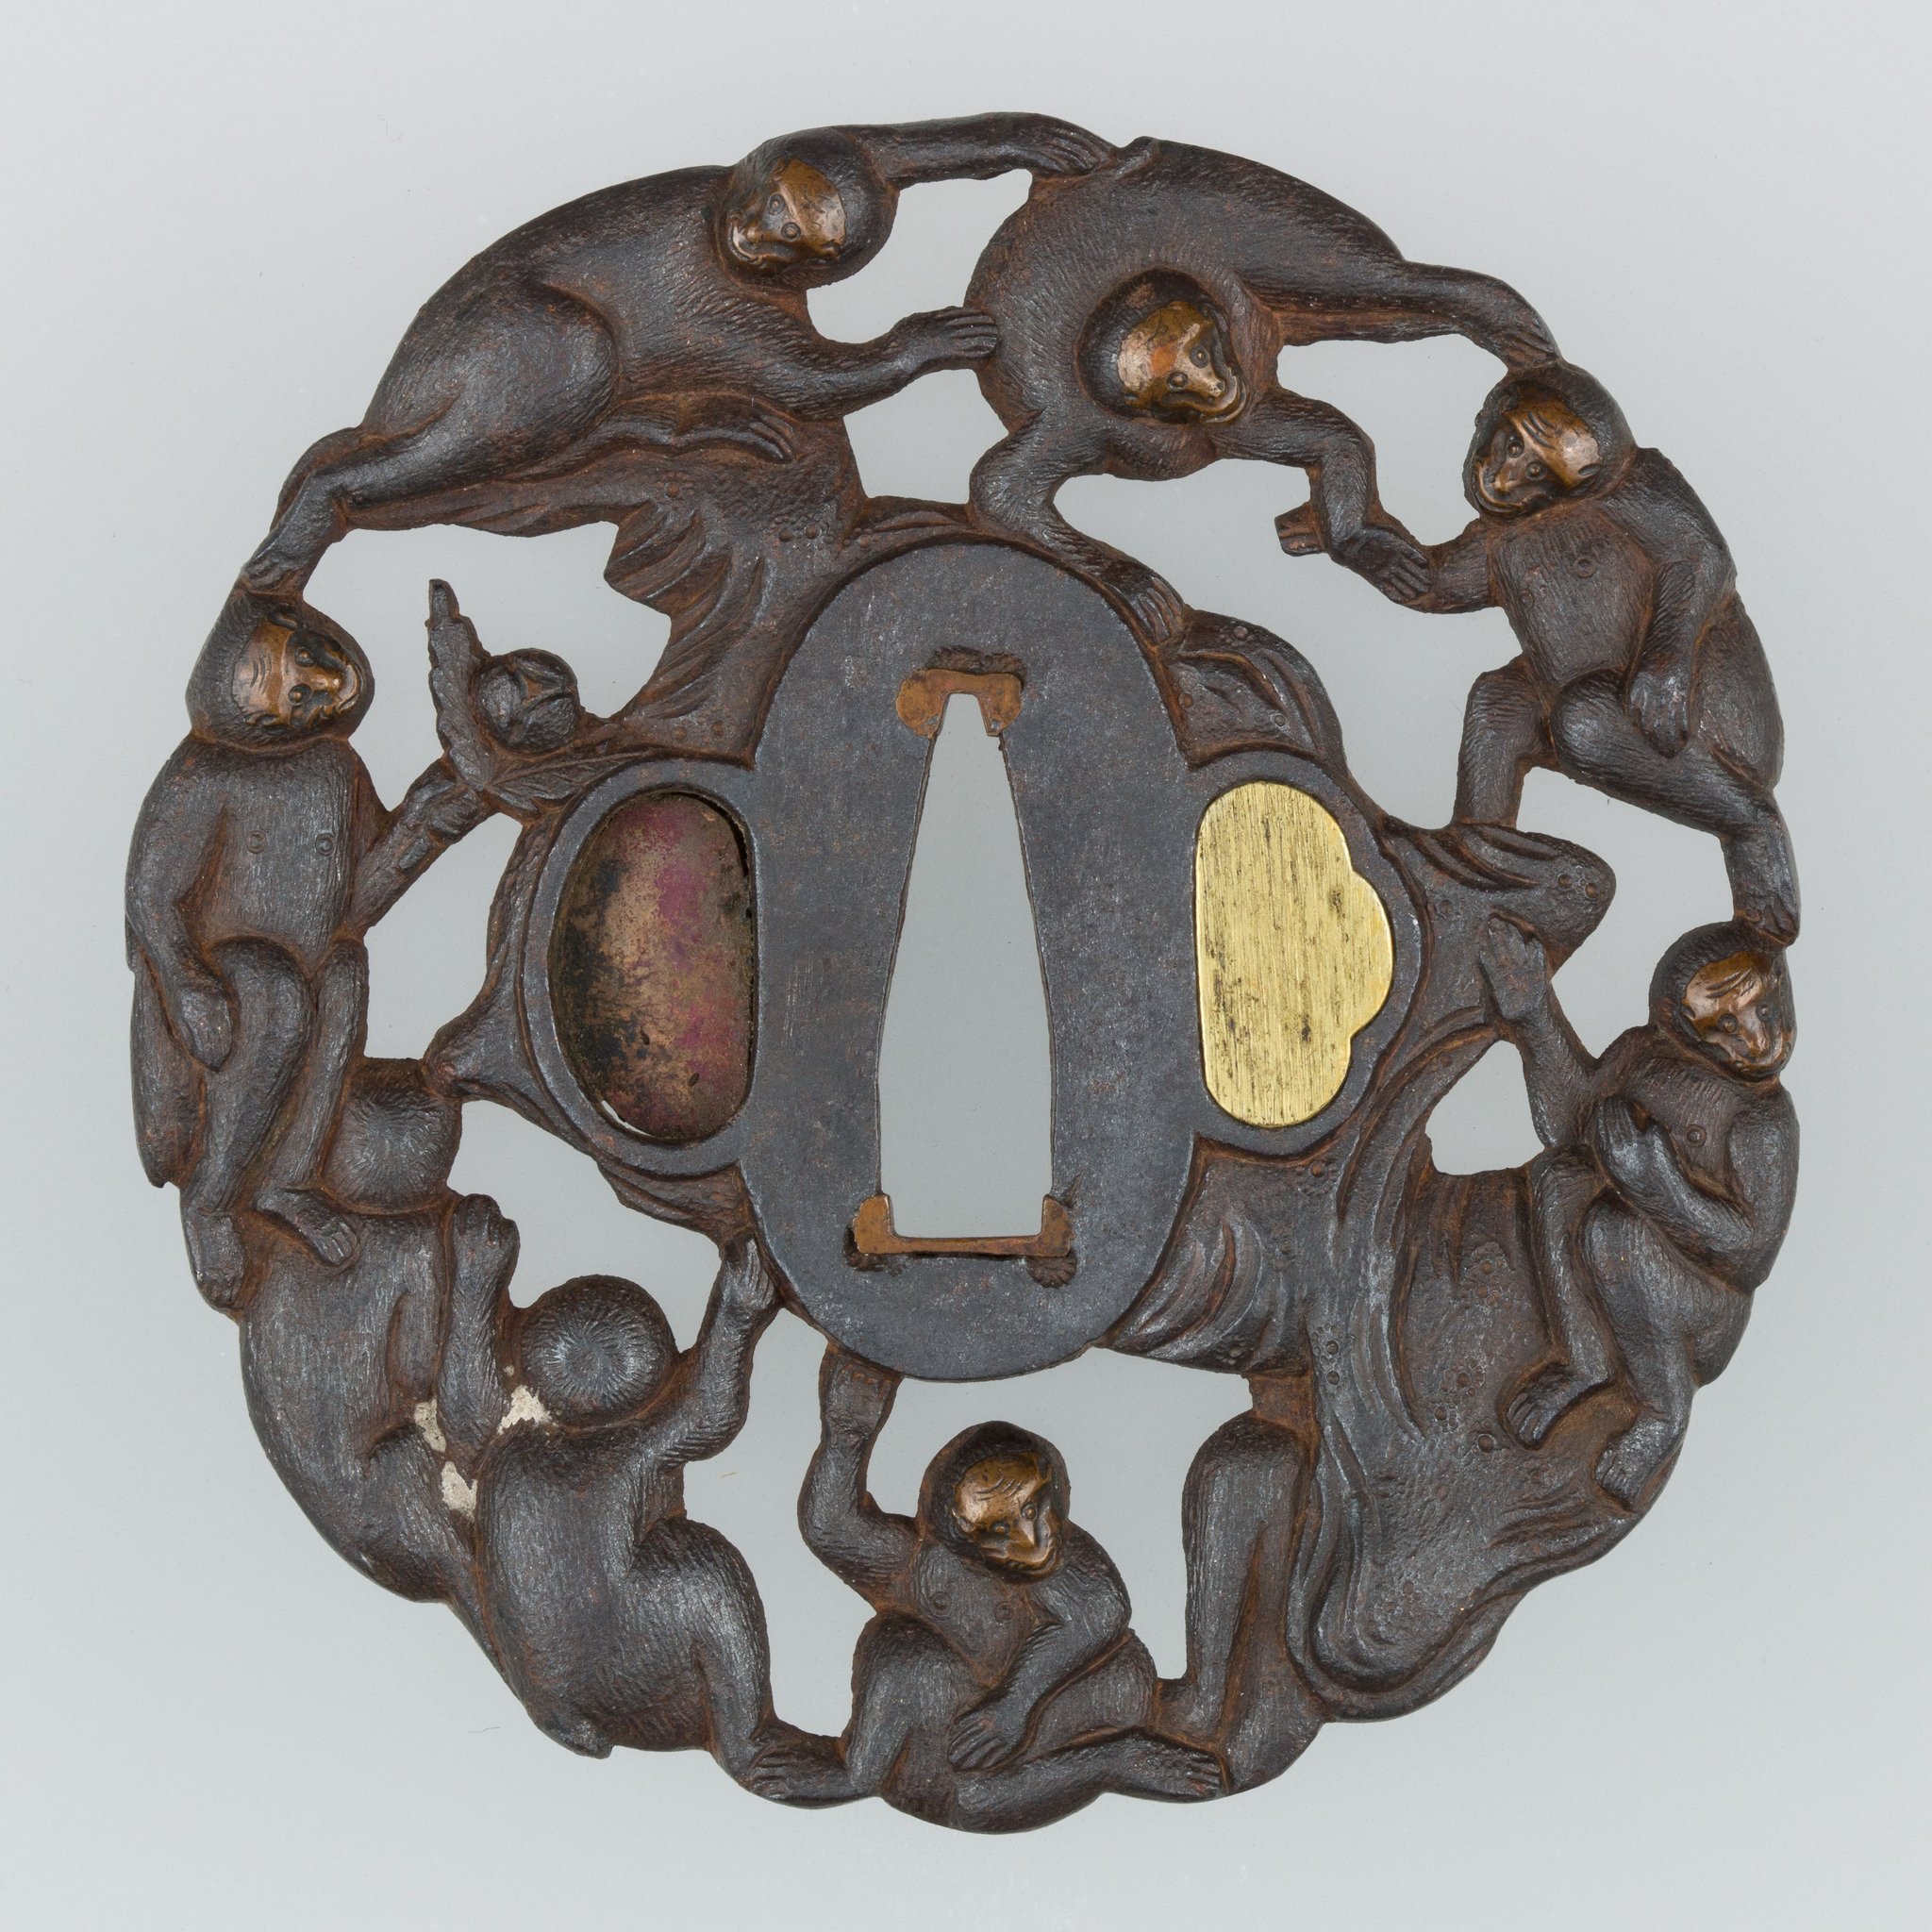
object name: sword guard tsuba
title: Sword Guard (Tsuba) Depicting Group of Monkeys in a Peach Tree (猿猴摘桃透鐔)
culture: japanese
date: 1615-1868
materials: copper, gold, iron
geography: japan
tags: monkeys